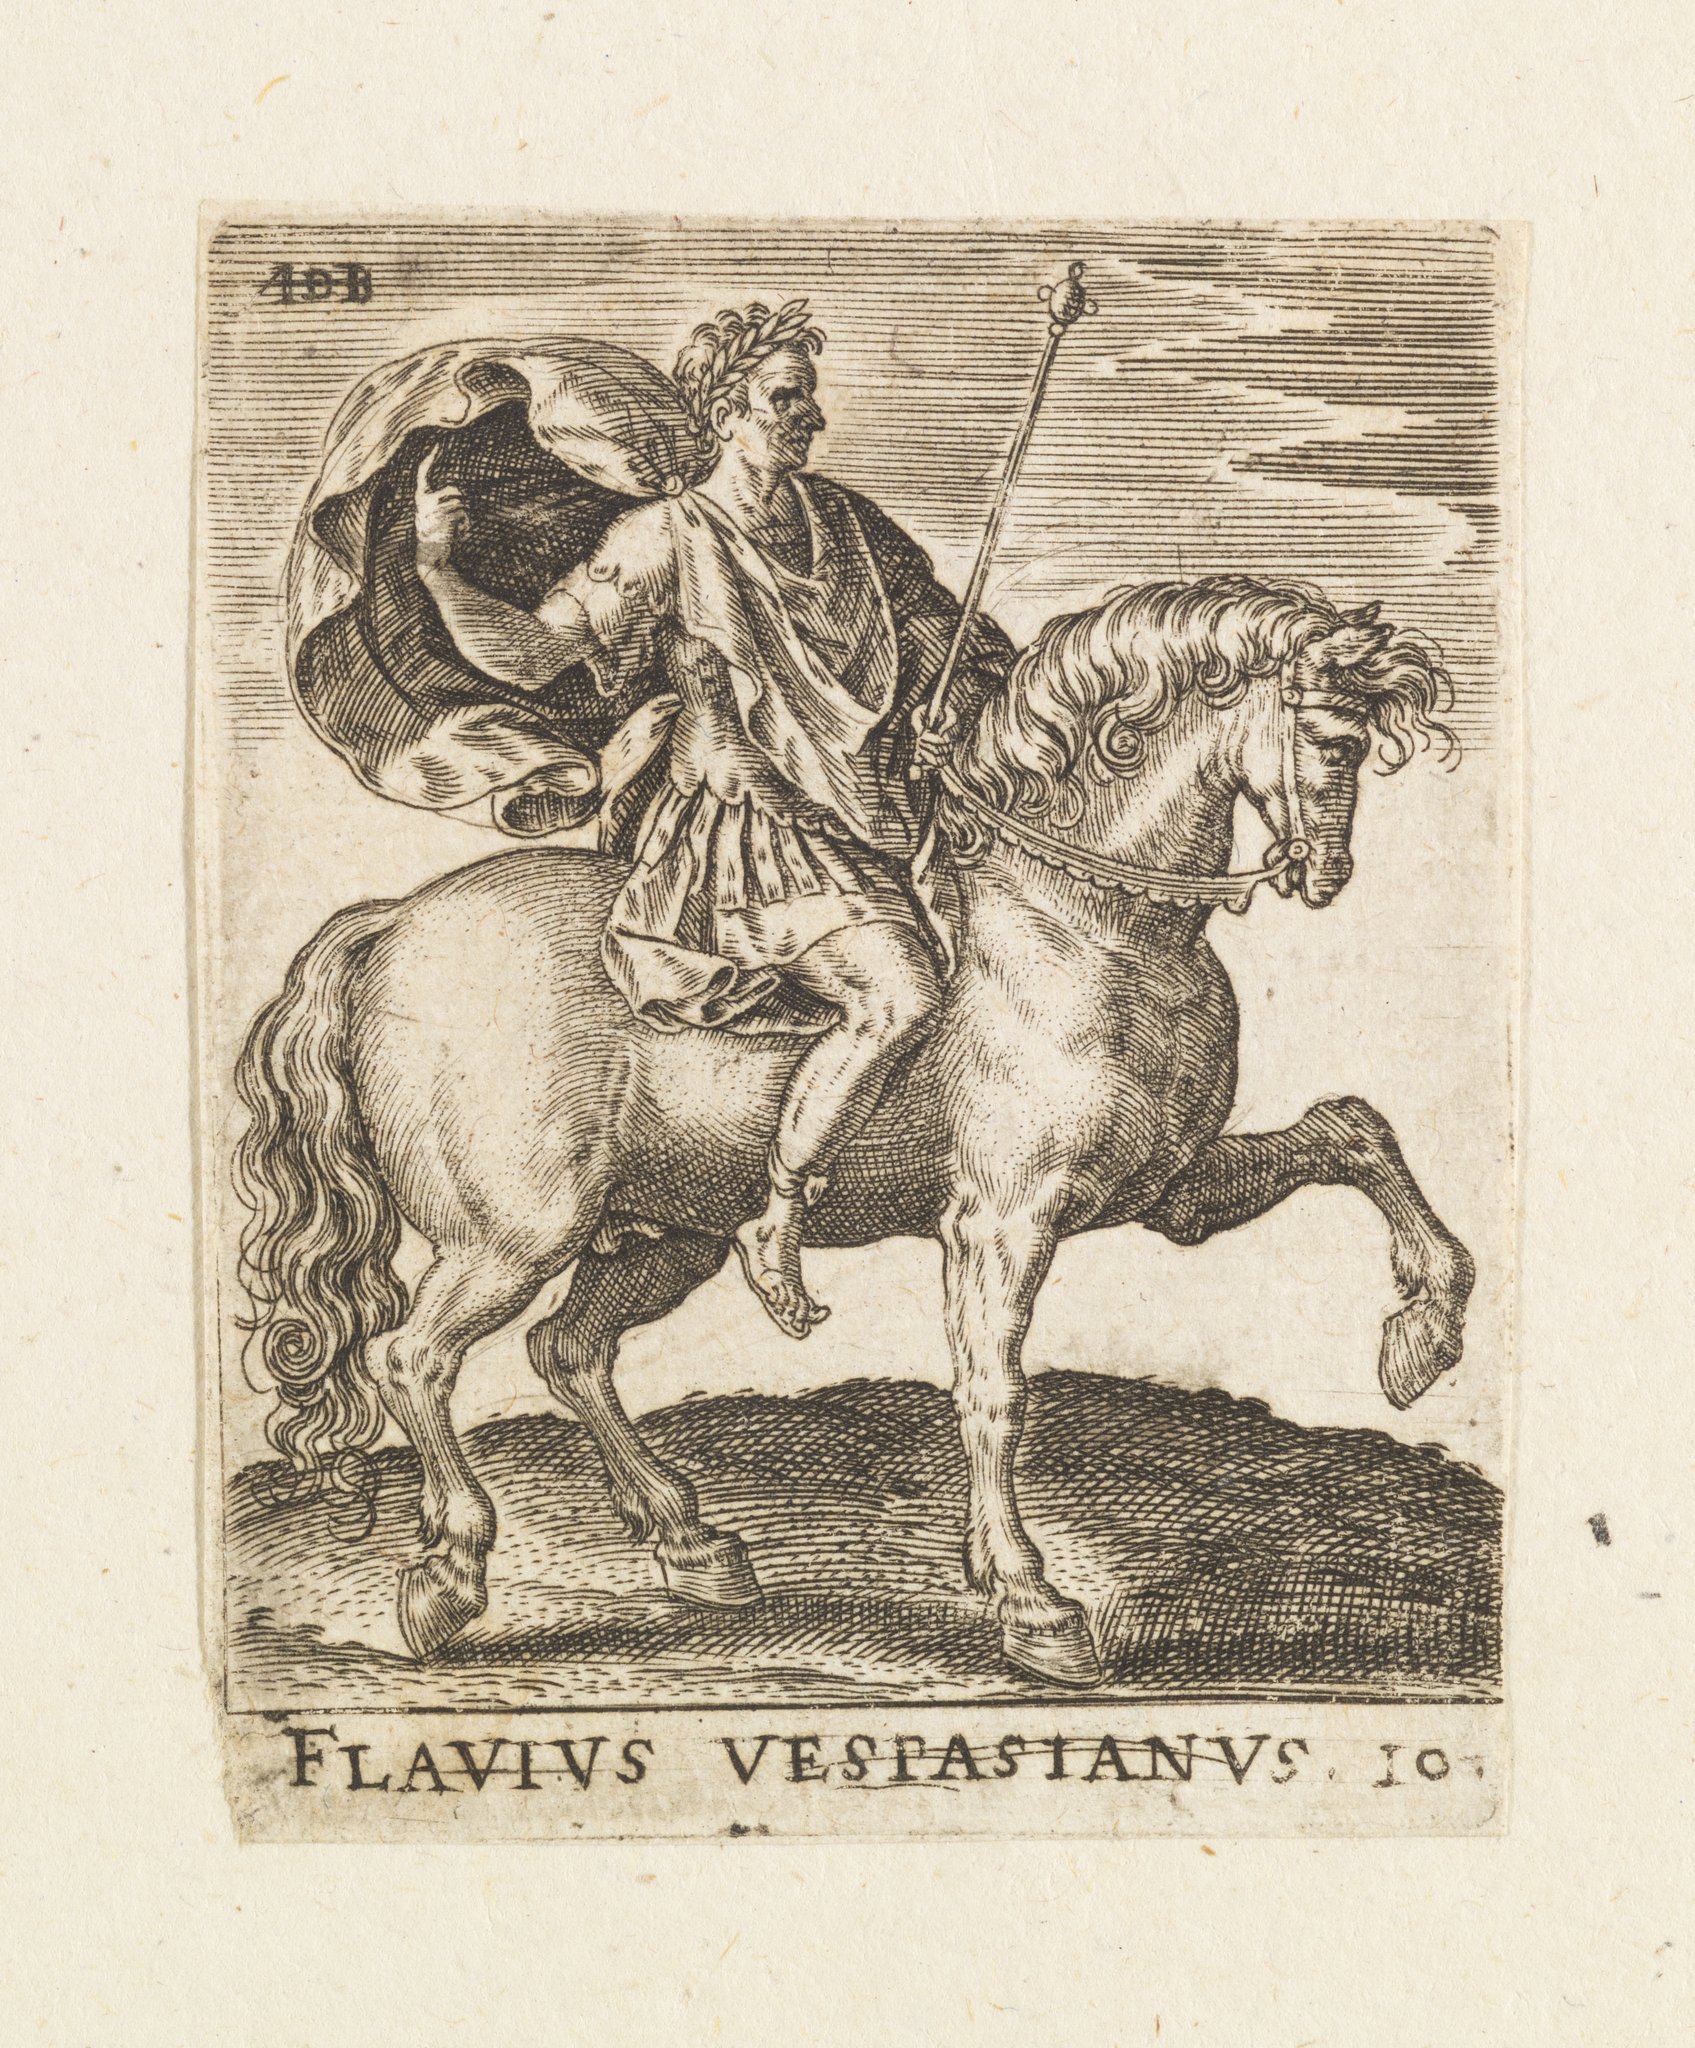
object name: print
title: Flavius Vestasianus, from "Twelve Caesars on Horseback"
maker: abraham de bruyn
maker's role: artist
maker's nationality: flemish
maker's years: 1540-1587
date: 1565-1587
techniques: engraving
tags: men,horses